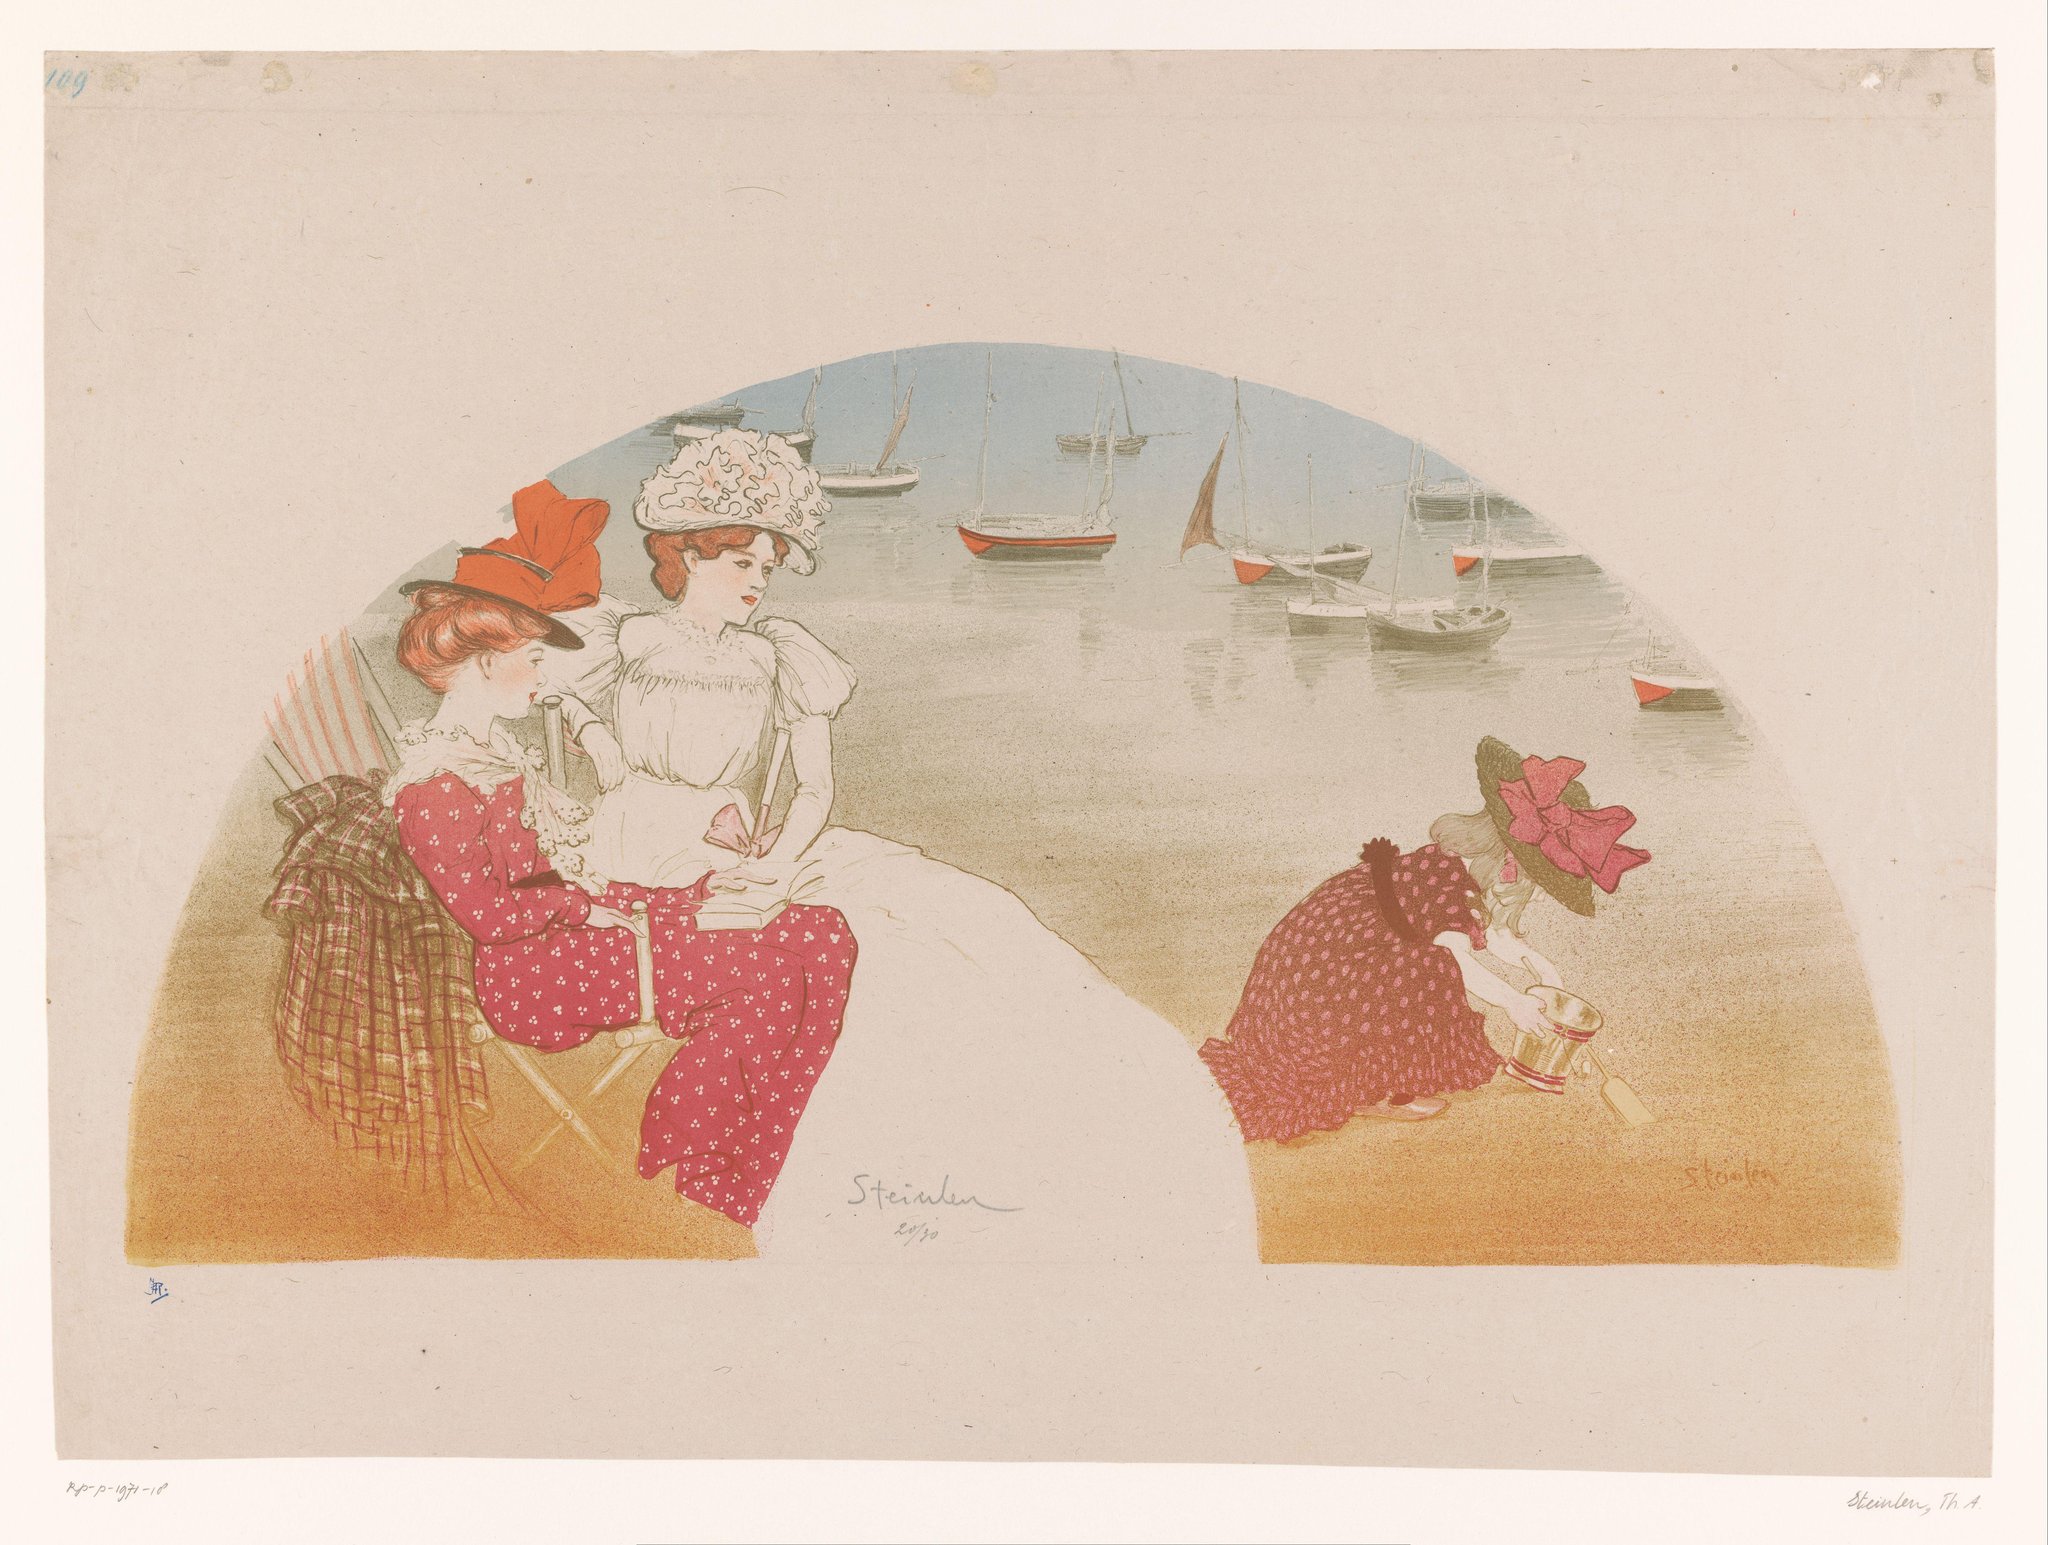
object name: print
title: Twee vrouwen en een kind aan zee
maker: théophile alexandre steinlen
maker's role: draughtsman, painter, print maker, sculptor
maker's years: 1859-1923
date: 1900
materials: paper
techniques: lithograph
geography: paris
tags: sailing-ship, sailing-boat, in or beside the water (on the beach)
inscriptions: collector's mark: Lugt 2760, collector's mark: Lugt 1516a, collector's mark: Lugt 2228